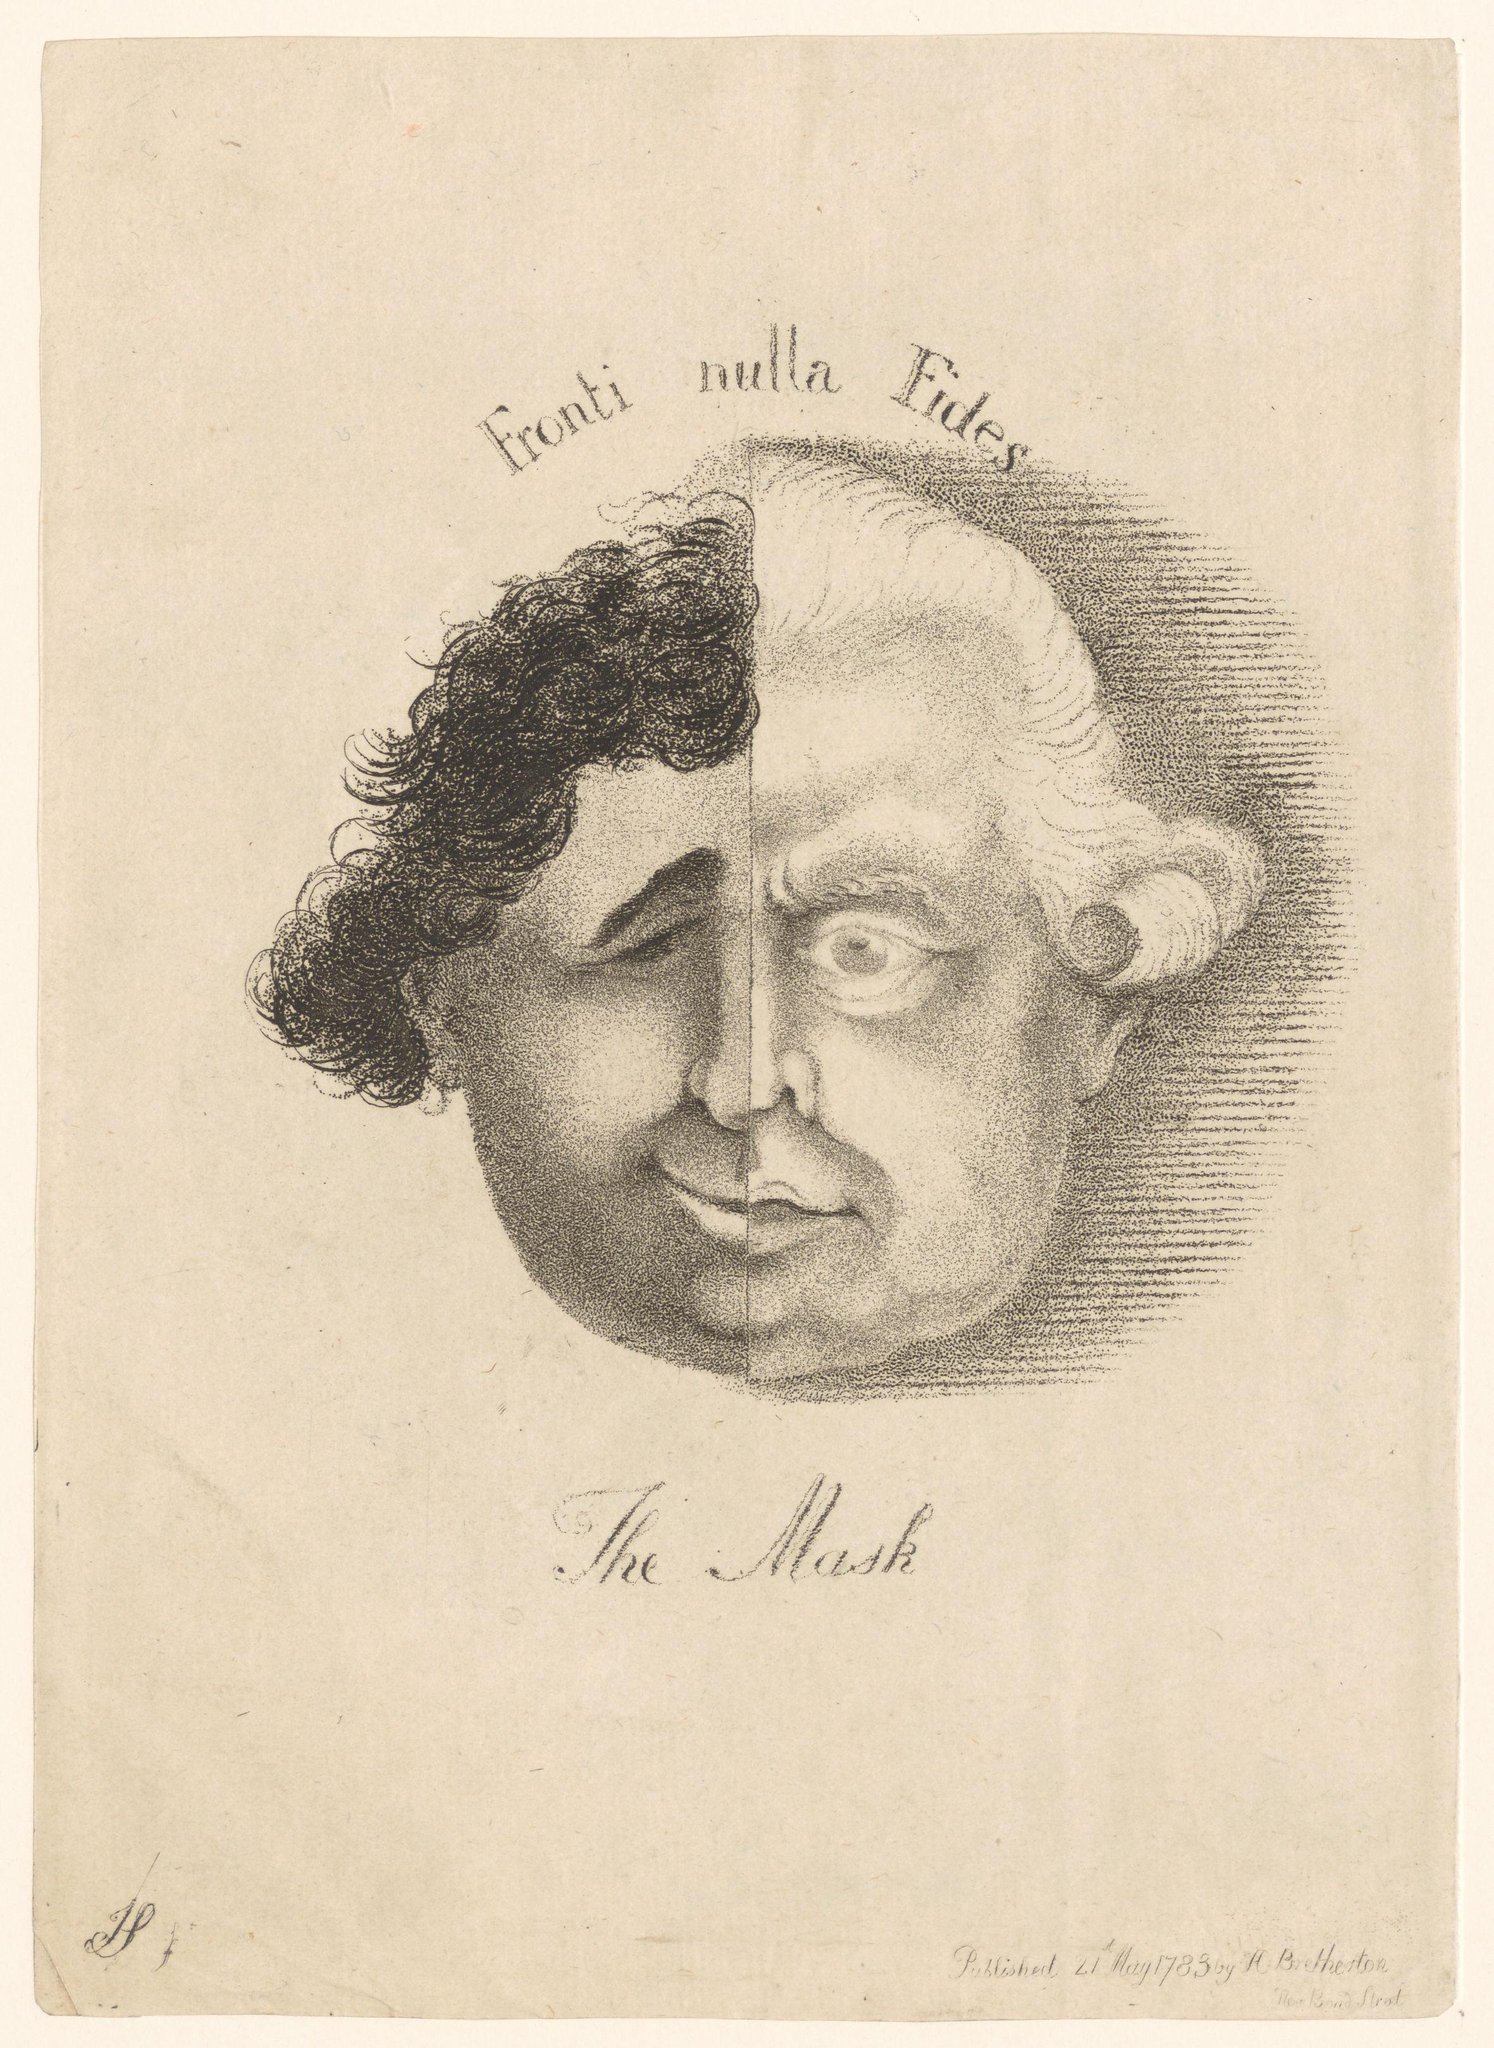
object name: print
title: The Mask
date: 1783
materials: paper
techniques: etching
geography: london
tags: mask, face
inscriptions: collector's mark: Lugt 2228